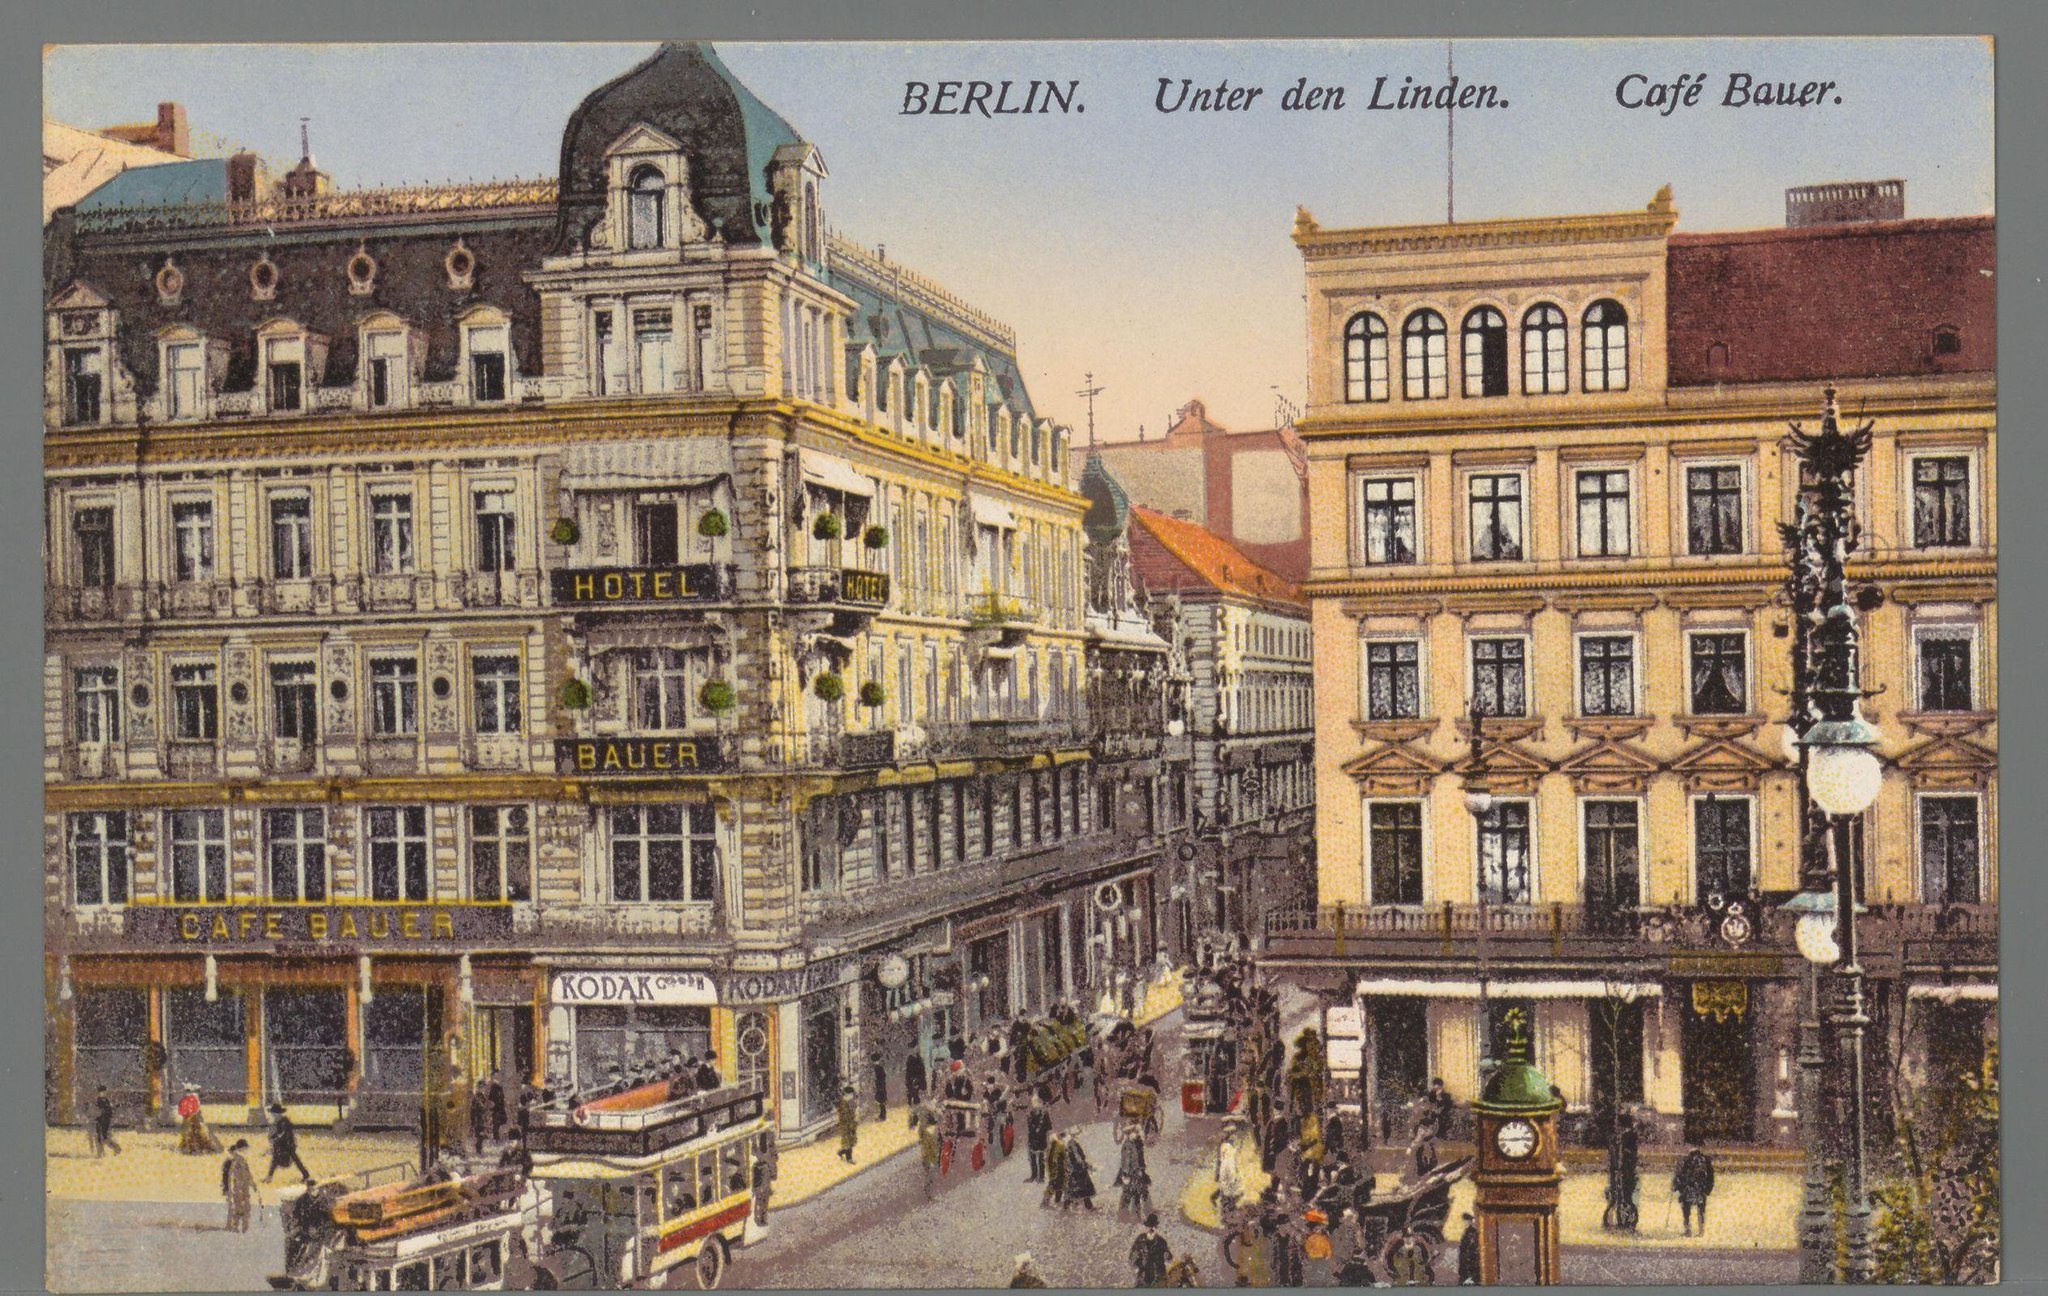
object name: photomechanical print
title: Berlin. Unter den Linden. Café Bauer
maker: Anonymous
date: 1905-1930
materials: cardboard, photographic process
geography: berlin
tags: street, hotel, hostelry, inn